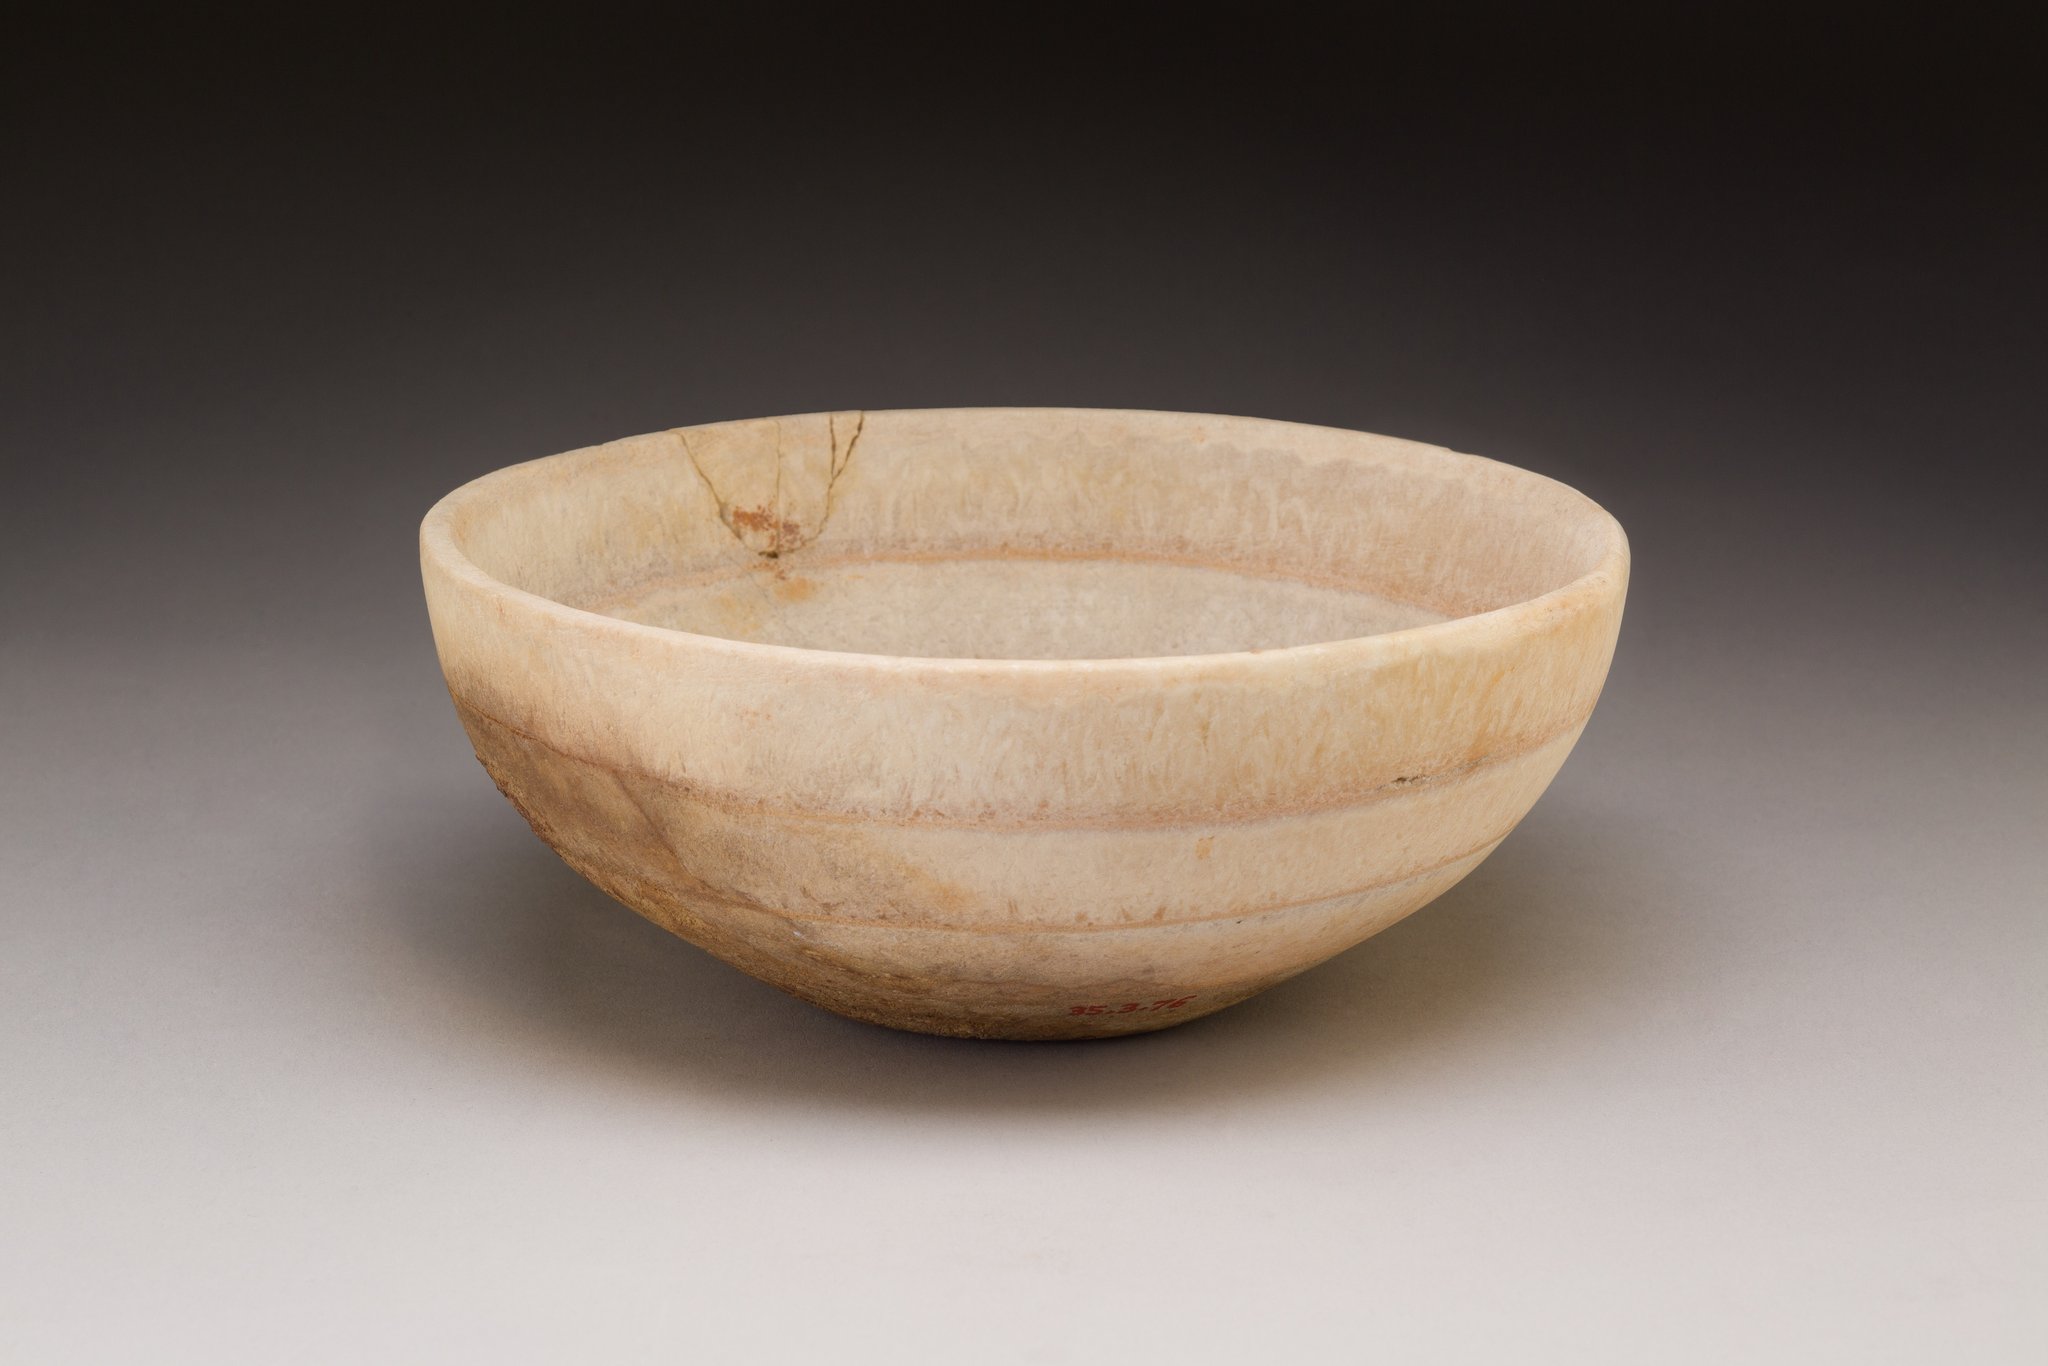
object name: bowl, rennefer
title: Bowl of Rennefer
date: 1504-1447 BCE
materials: stone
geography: egypt